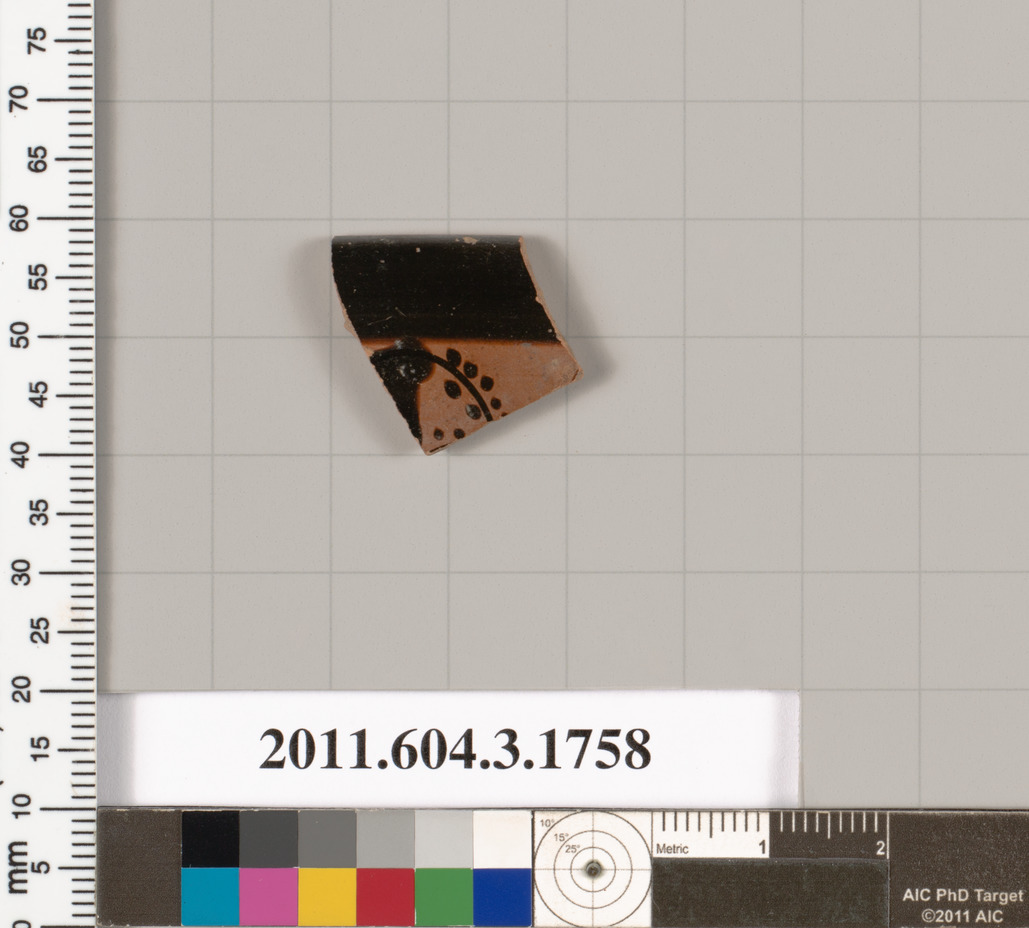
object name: kylix fragment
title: Terracotta rim fragment of a kylix: Band cup (drinking cup)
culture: greek, attic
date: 550-526 BCE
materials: terracotta